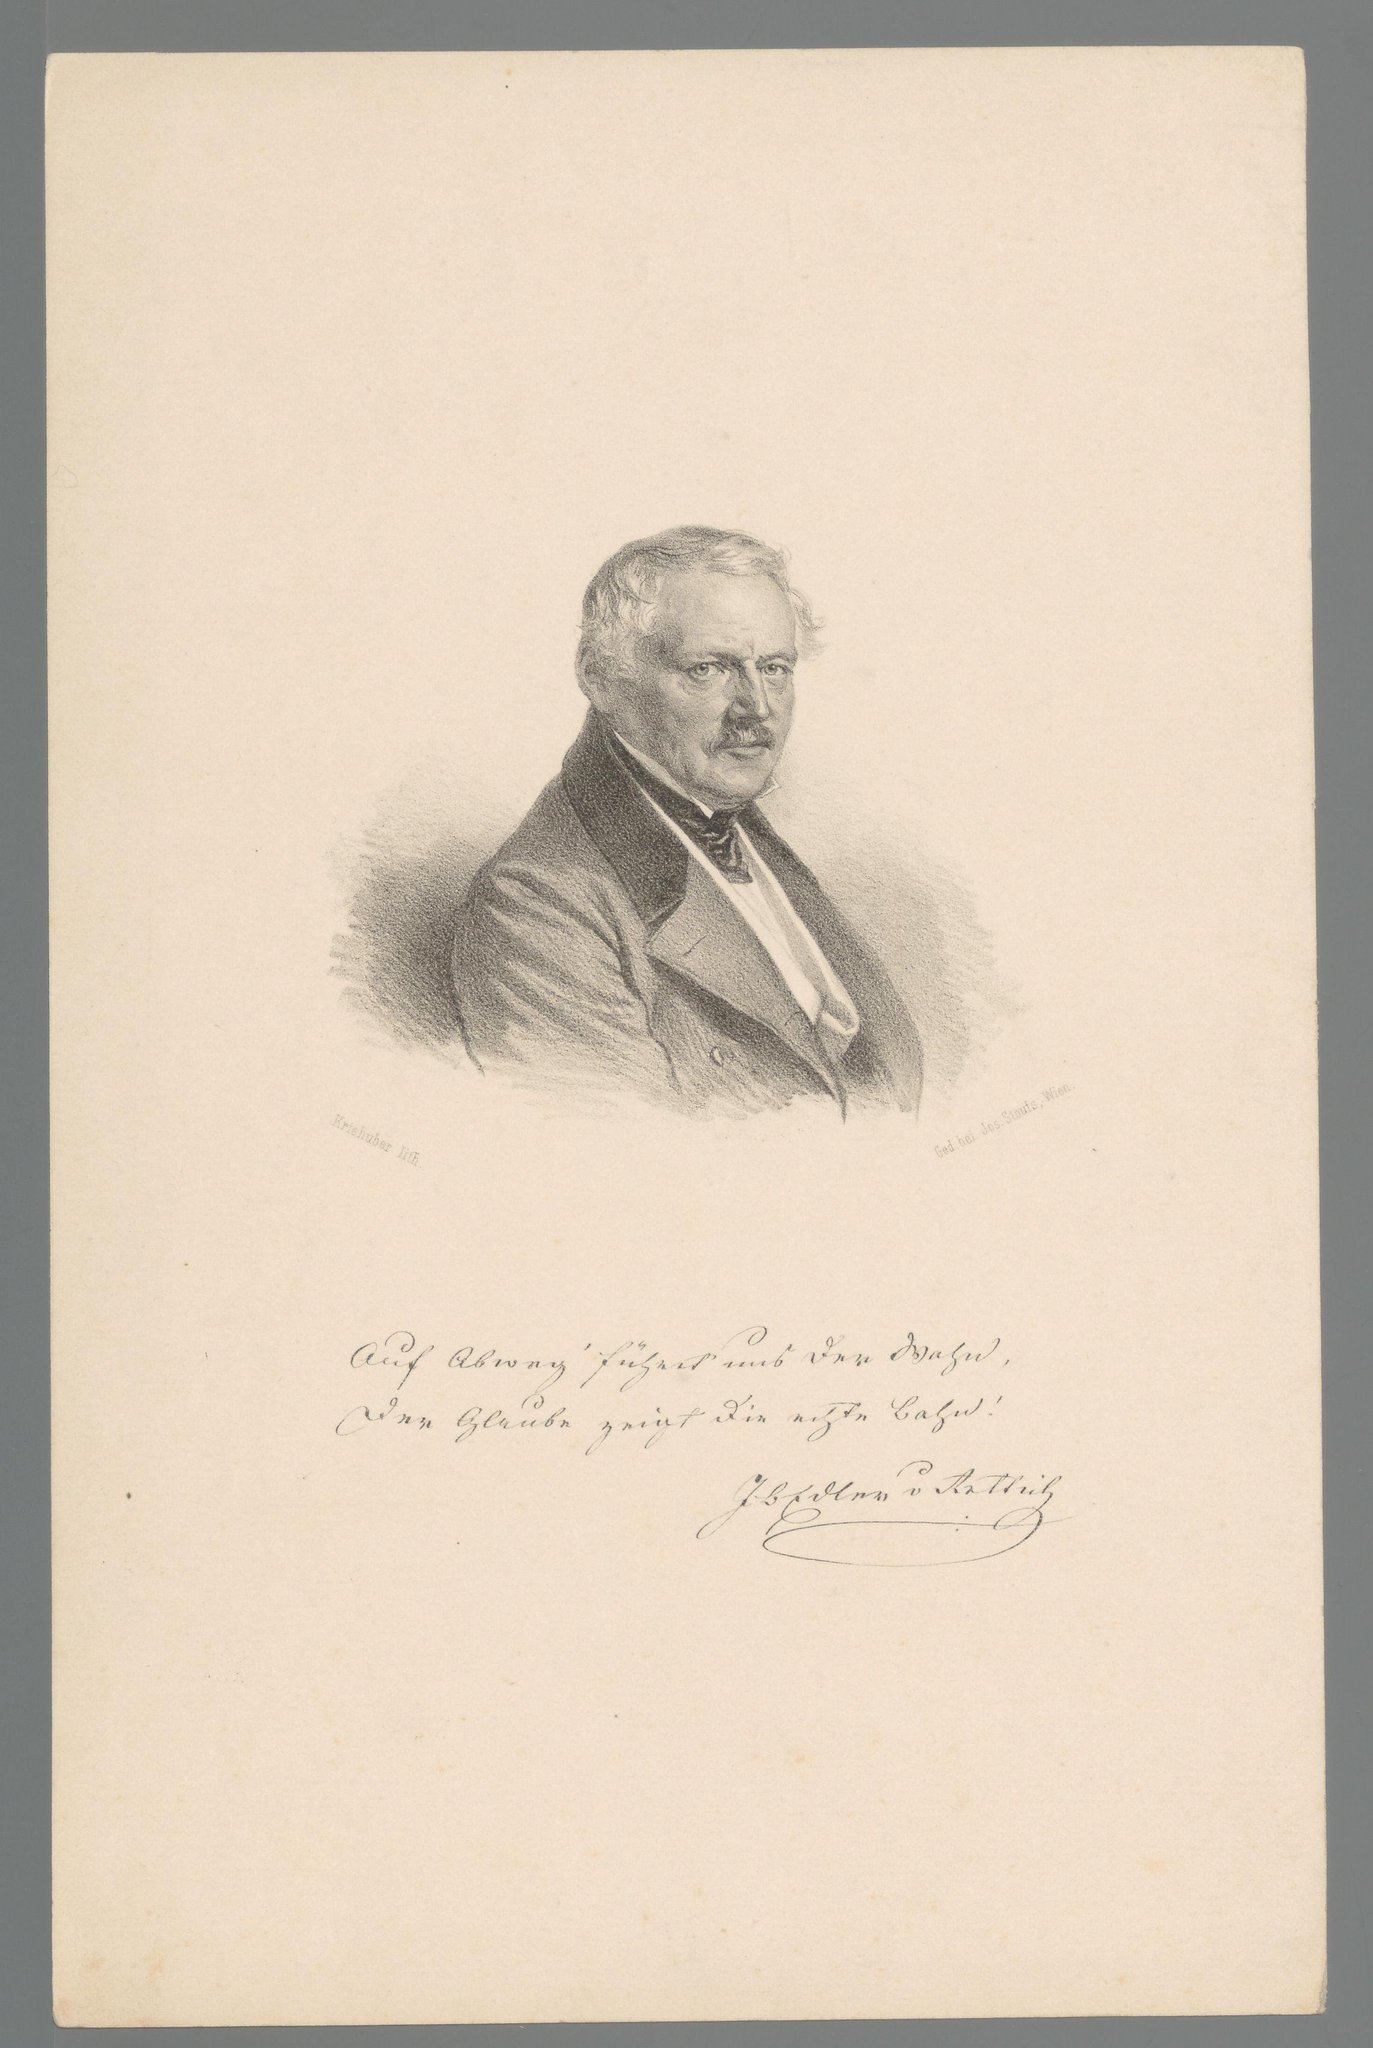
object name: print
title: Portret van Johann Baptist von Rettich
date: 1810-1876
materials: paper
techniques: lithograph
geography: vienna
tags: historical persons, portrait of a writer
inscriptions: collector's mark: Lugt 2228